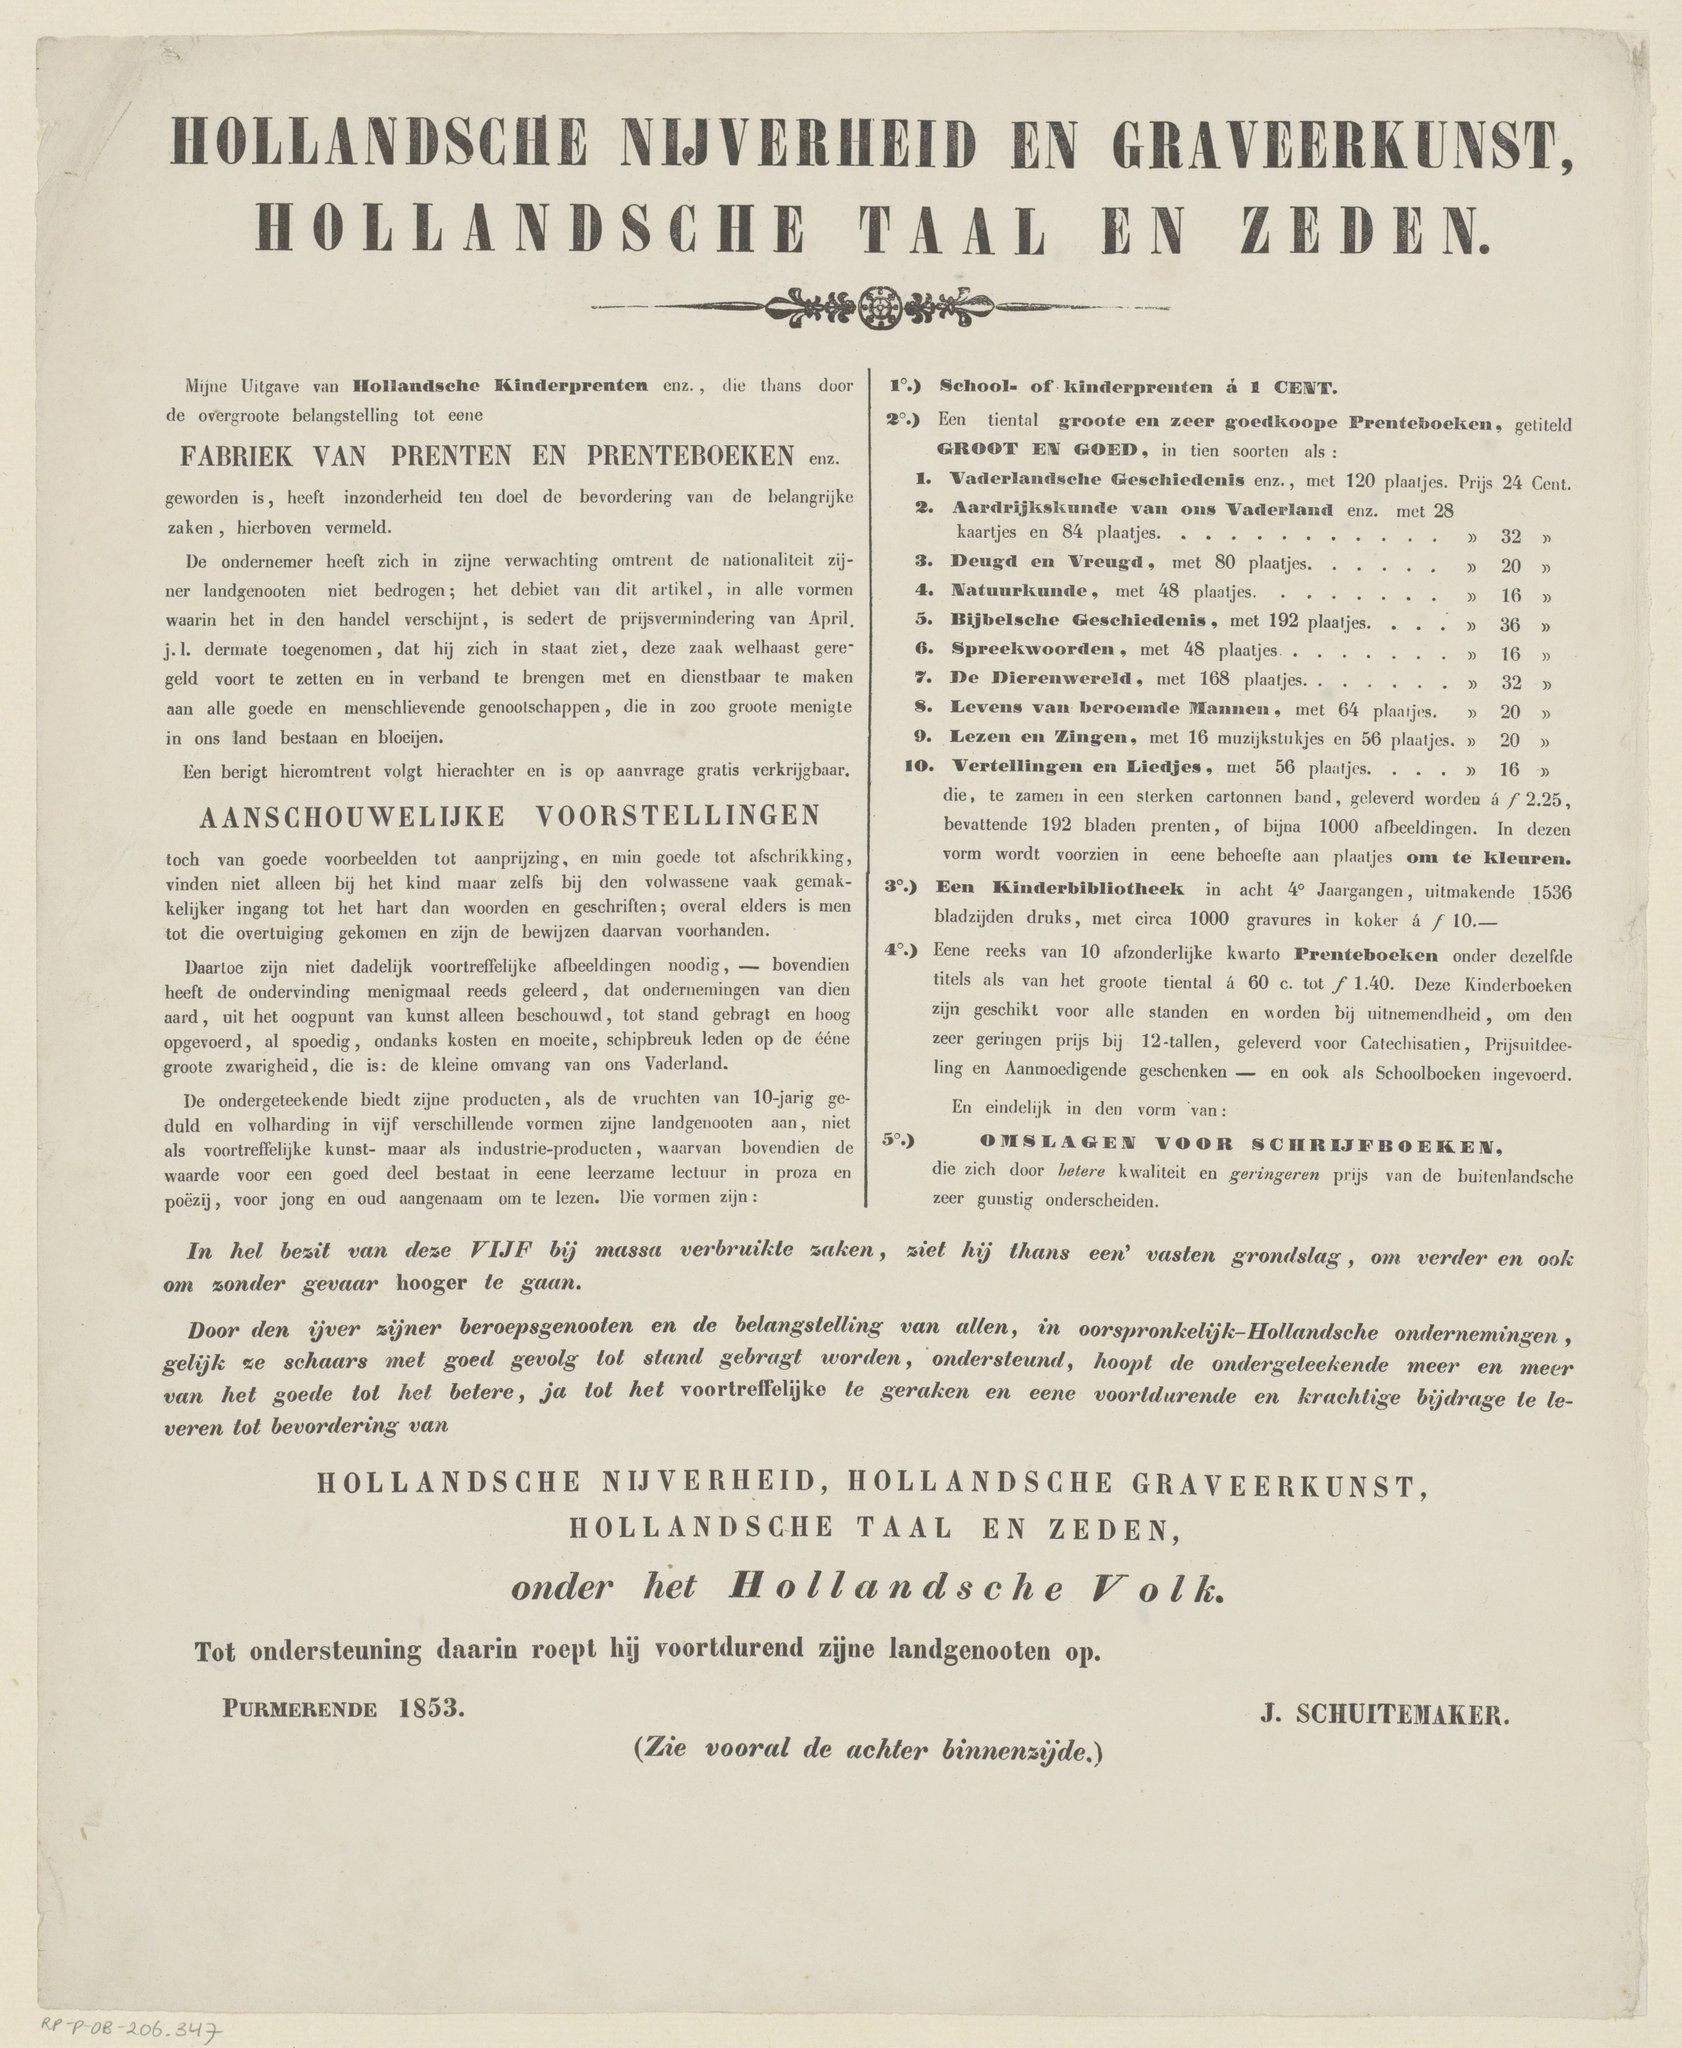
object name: uitgeversbrochure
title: Hollandsche nijverheid en graveerkunst, Hollandsche taal en zeden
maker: jan schuitemaker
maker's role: draughtsman, publisher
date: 1853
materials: paper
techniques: letterpress printing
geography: purmerend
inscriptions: collector's mark: Lugt 2760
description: Tekstblad met een beschrijving van het aanbod van de uitgever Jan Schuitemaker uit Purmerend. Blad aan één zijde bedrukt.